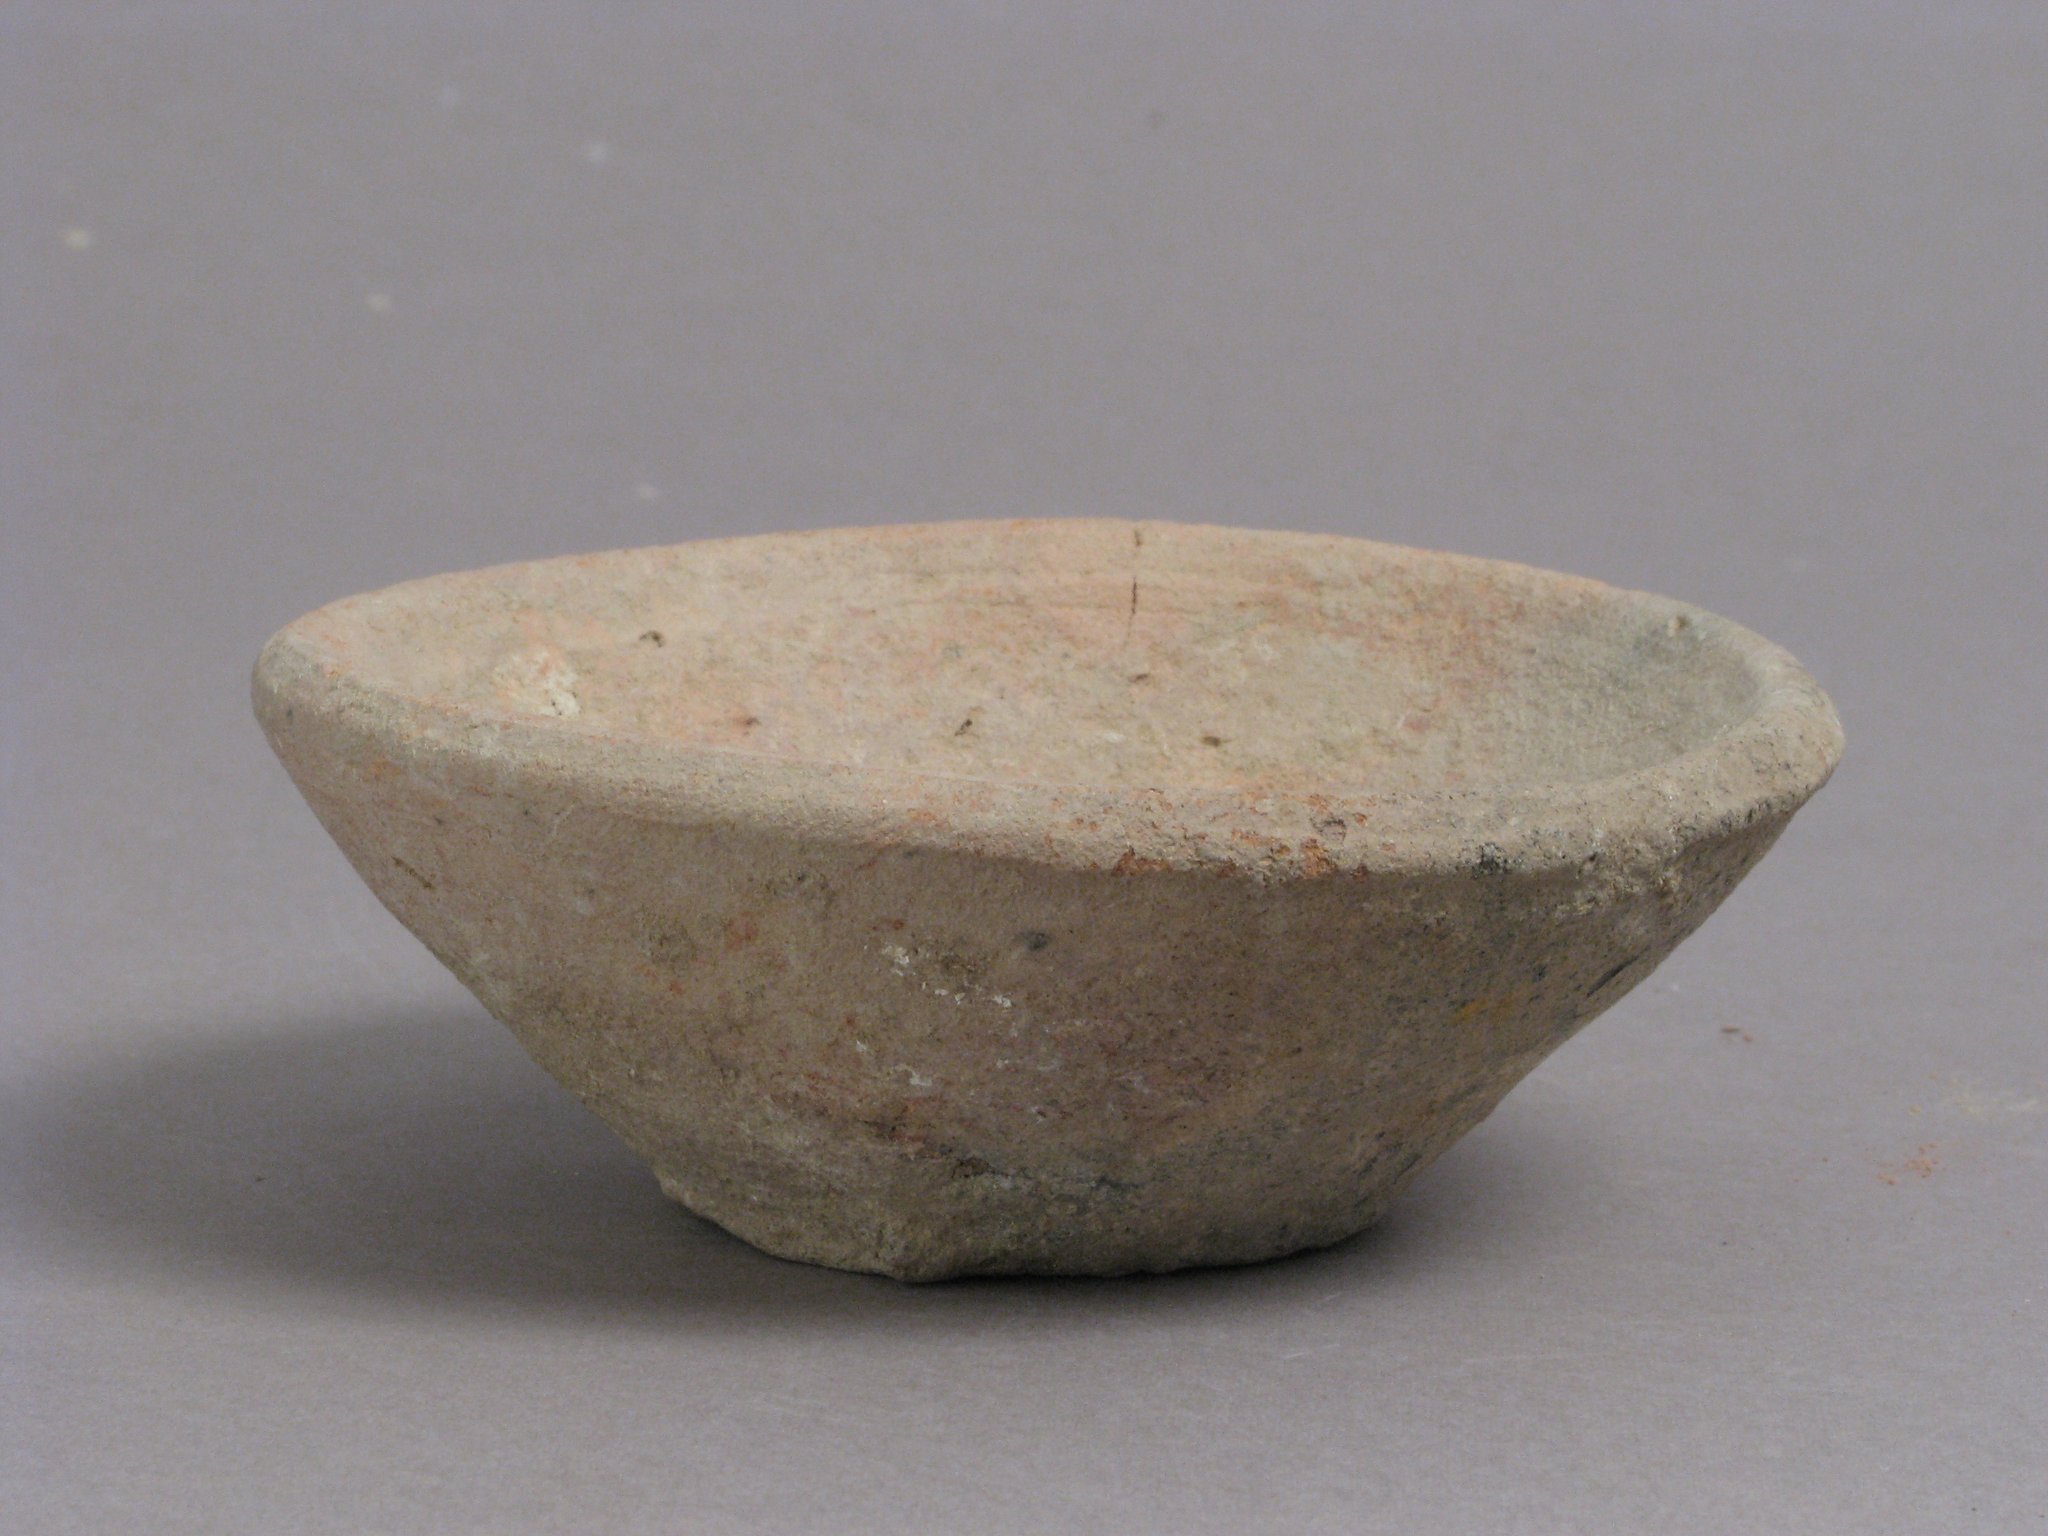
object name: bowl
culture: coptic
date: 301-700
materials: earthenware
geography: egypt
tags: bowls